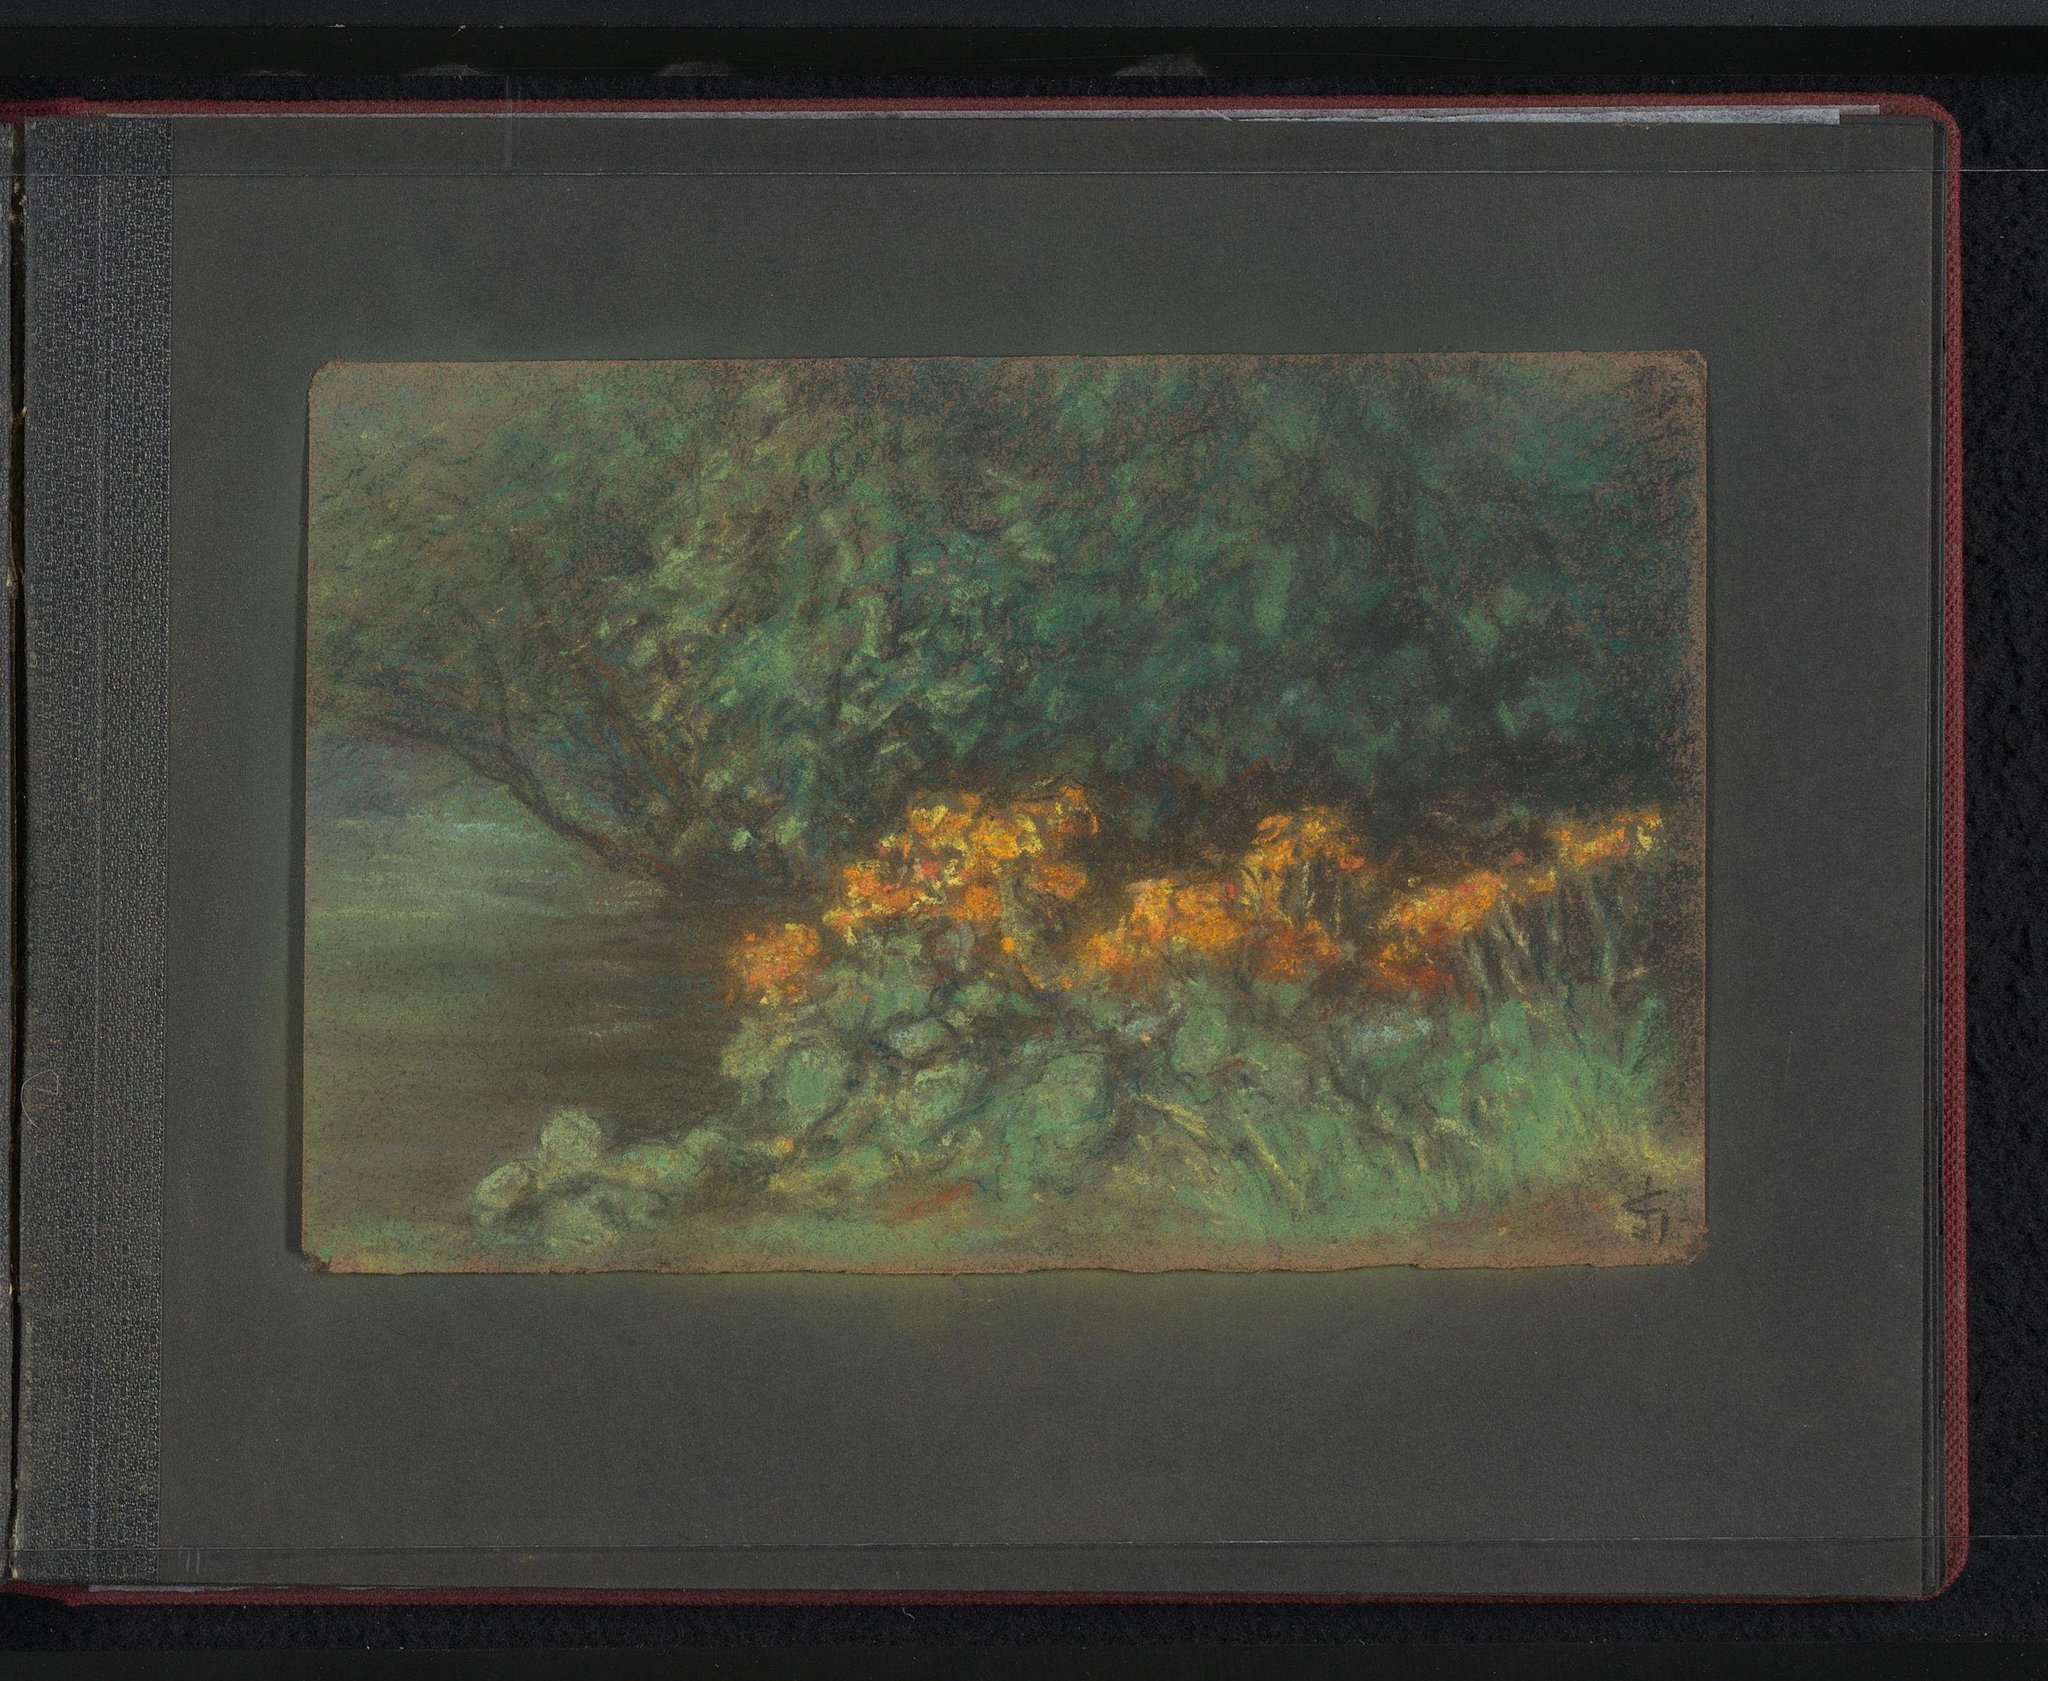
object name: drawing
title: Begroeiing met bloemen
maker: carel nicolaas storm van s-gravesande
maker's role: draughtsman, print maker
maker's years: 1841-1924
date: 1915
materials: chalk, paper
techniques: pasting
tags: garden pond, public gardens, park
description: Mogelijk in het Kurpark te Wiesbaden. Tekening maakt deel uit van een album.